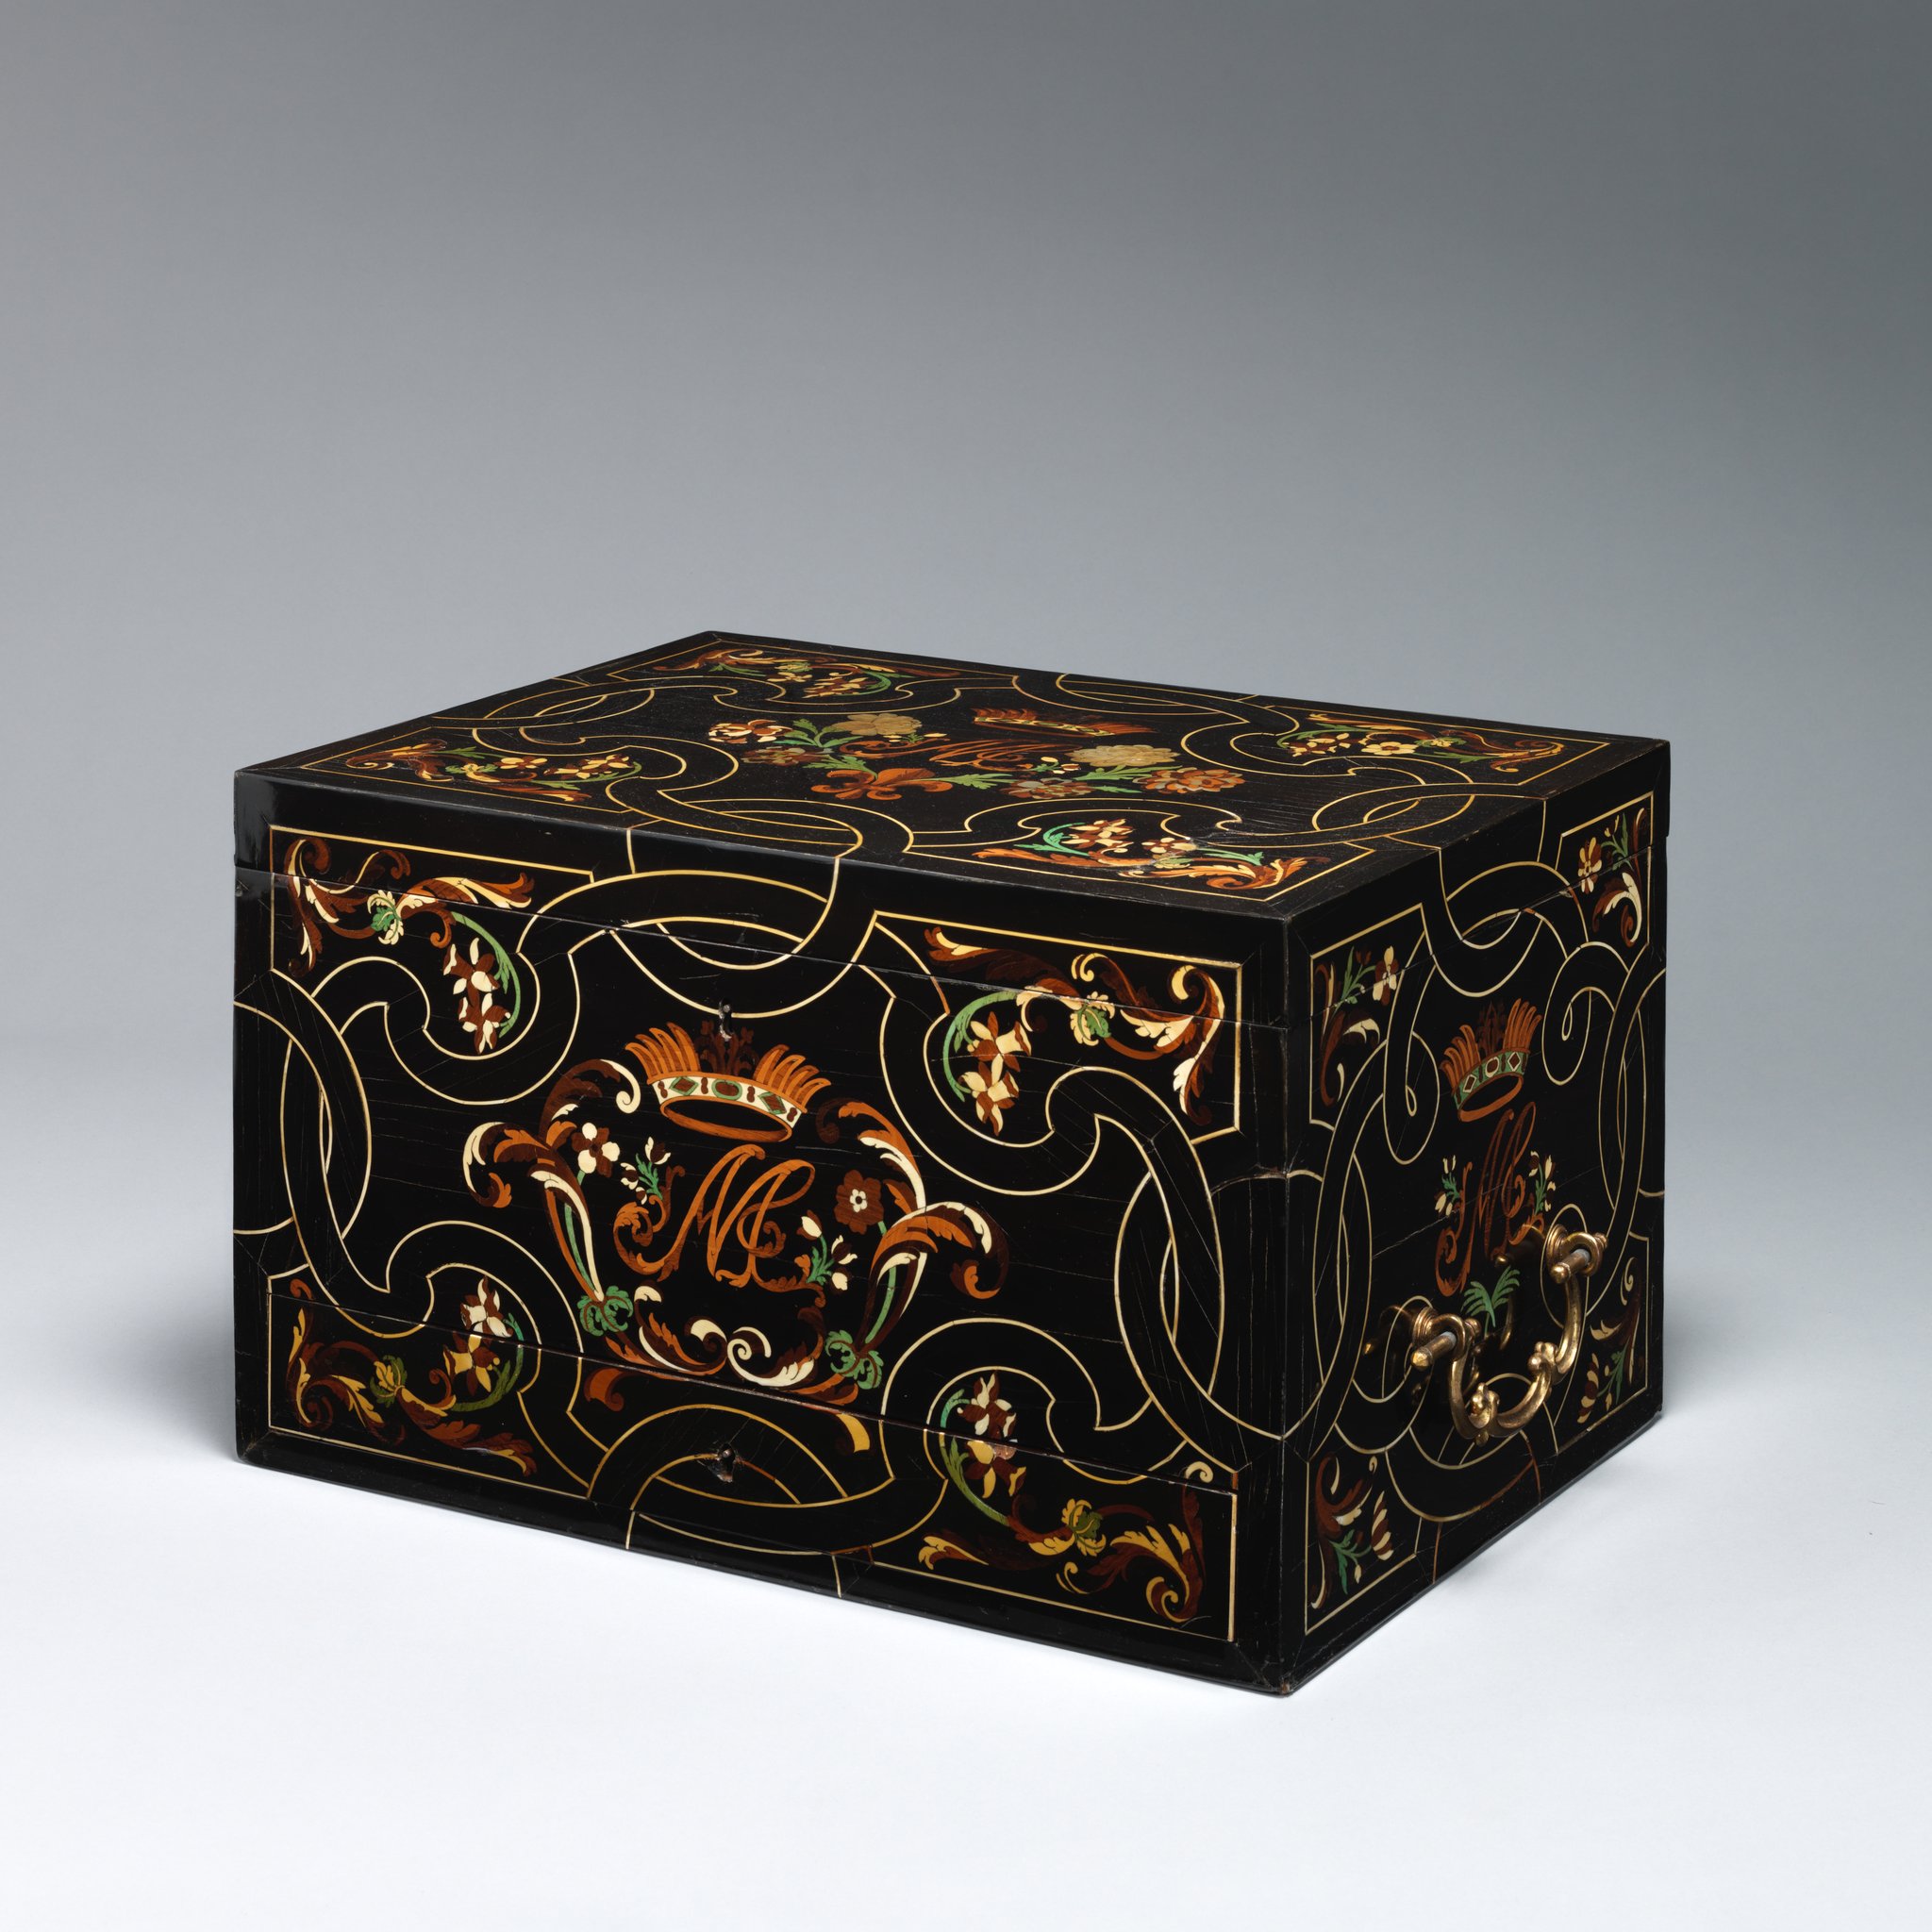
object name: coffer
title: Coffer with inlaid monogram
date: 1680-1700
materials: brass, wood, gilt bronze, horn, ivory, mother of pearl, velvet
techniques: stain